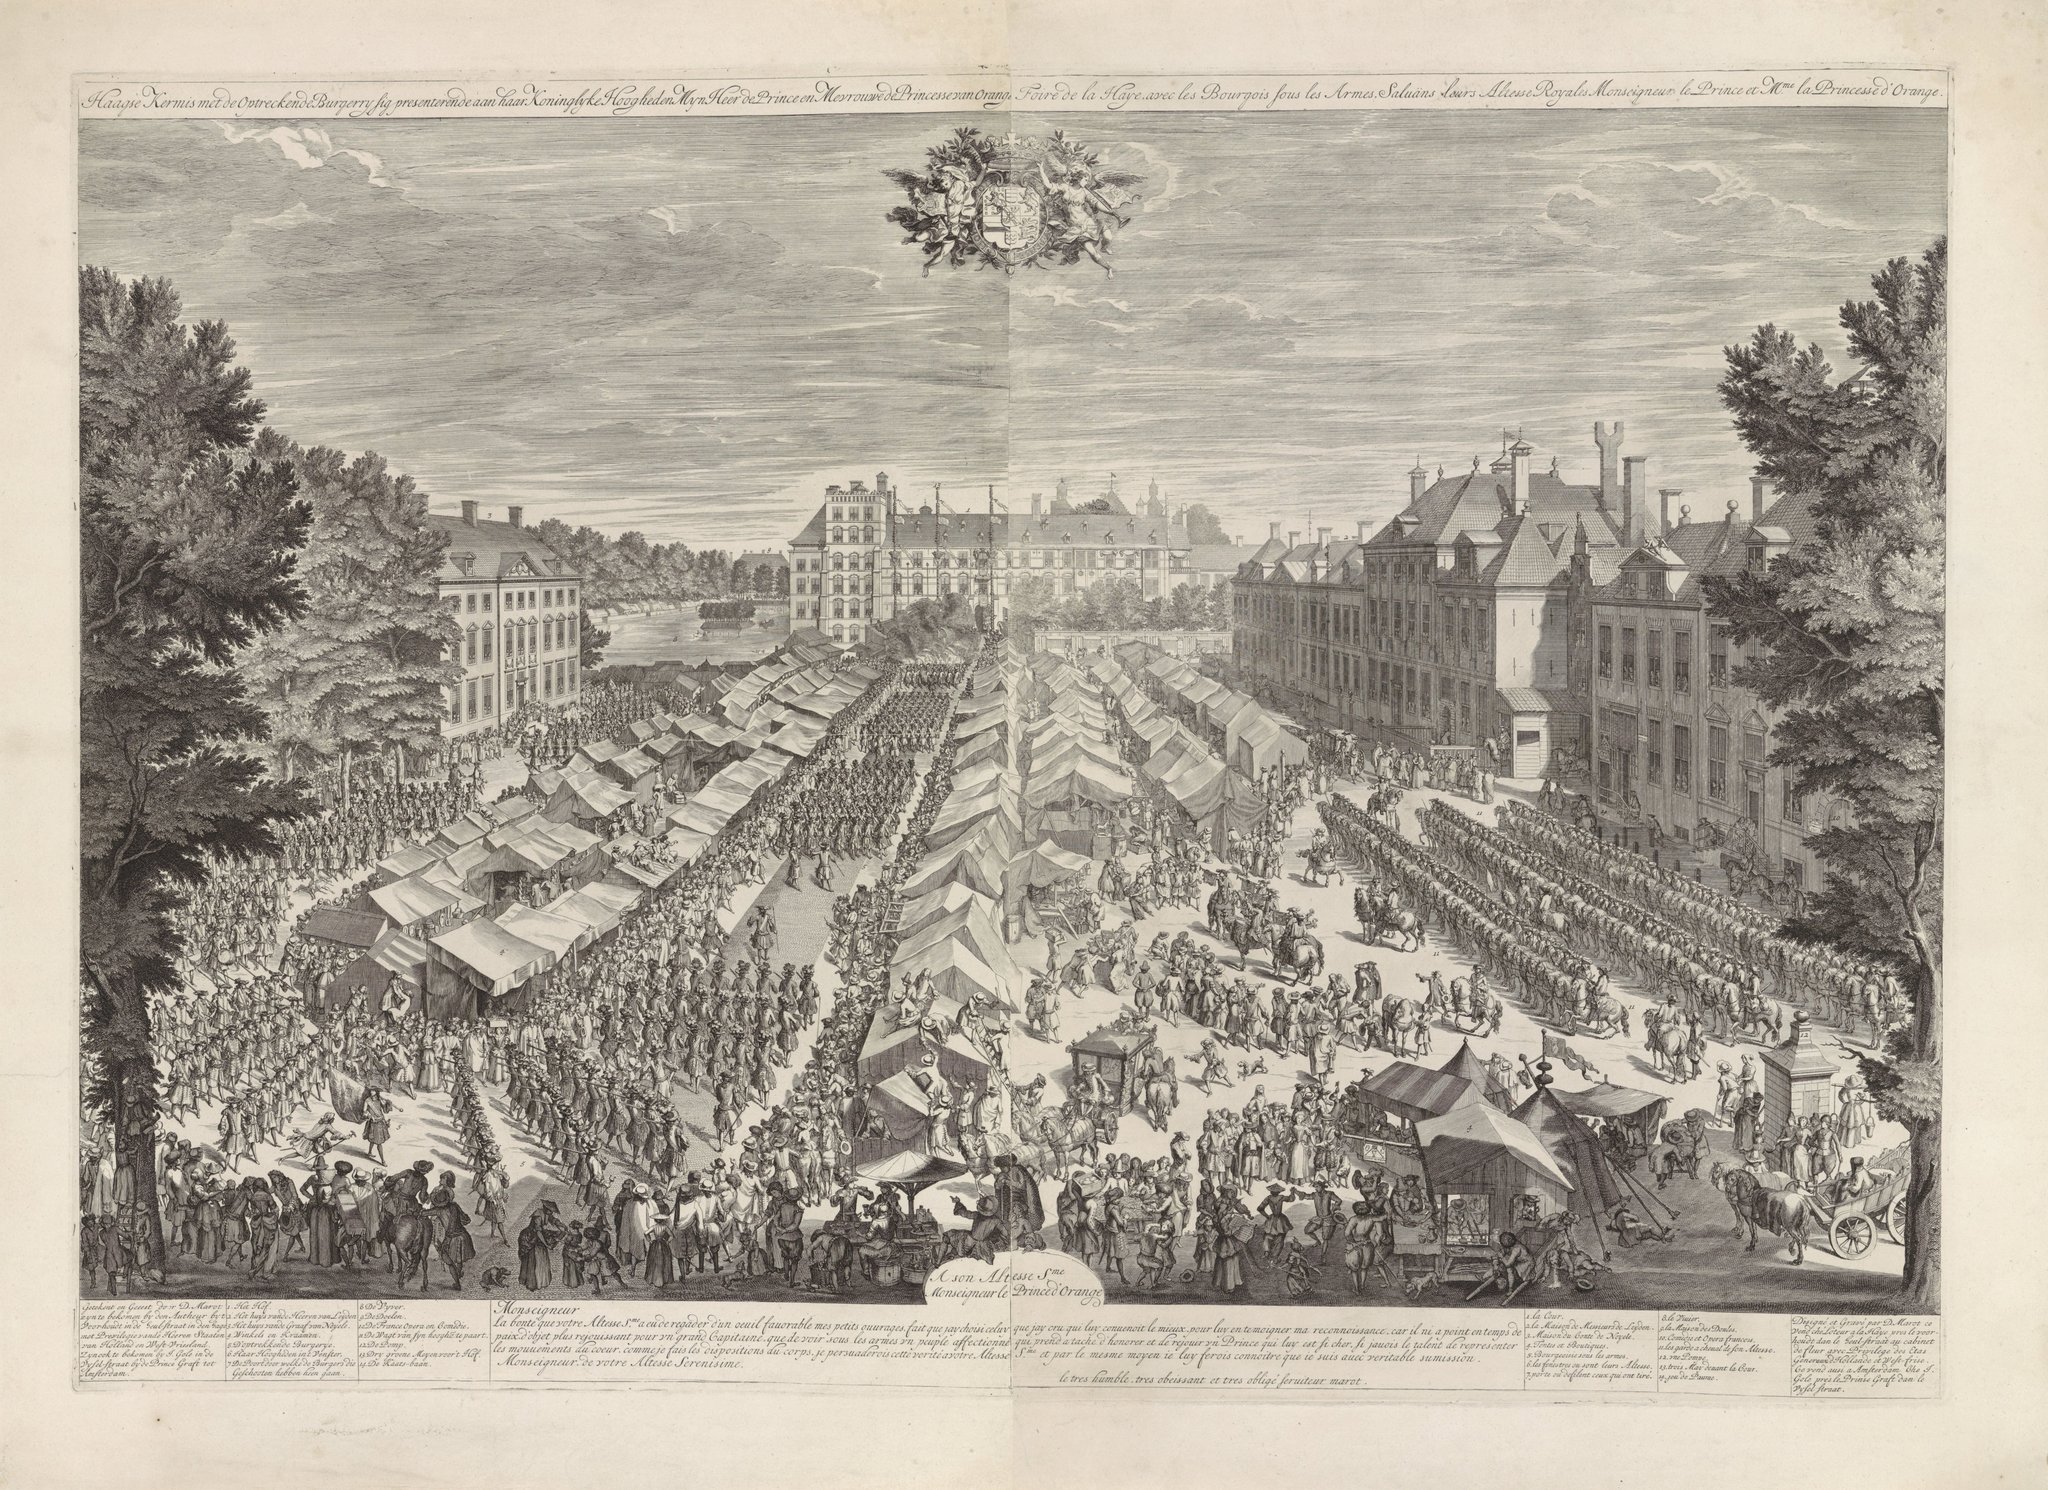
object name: print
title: Haagse Kermis met de prins en prinses van Oranje, 1686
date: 1686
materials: paper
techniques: engraving, etching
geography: the hague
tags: william iii (prince of orange and king of england, scotland, and ireland), london, maria ii stuart (koningin van engeland, schotland en ierland), (annual) fair, trade fair, armorial bearing, heraldry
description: Haagse kermis in 1686 gehouden op het Buitenhof, met de paraderende schutterij vanaf het Noyelleshuis (later Vijverhof) links tussen de kramen over de markt tot aan de poort waar saluutschoten worden gebracht voor het prinselijk paar dat vanuit het raam in het Stadhouderlijk Kwartier toekijkt. Rechts staat de wacht van de prins te paard opgesteld voor de Kaatsbaan en de Komedie. In de lucht twee engelen met het prinselijke wapen van Willem III. Onderaan de opdracht in 4 regels in het Frans en de legenda's 1-14 in het Nederlands en Frans.